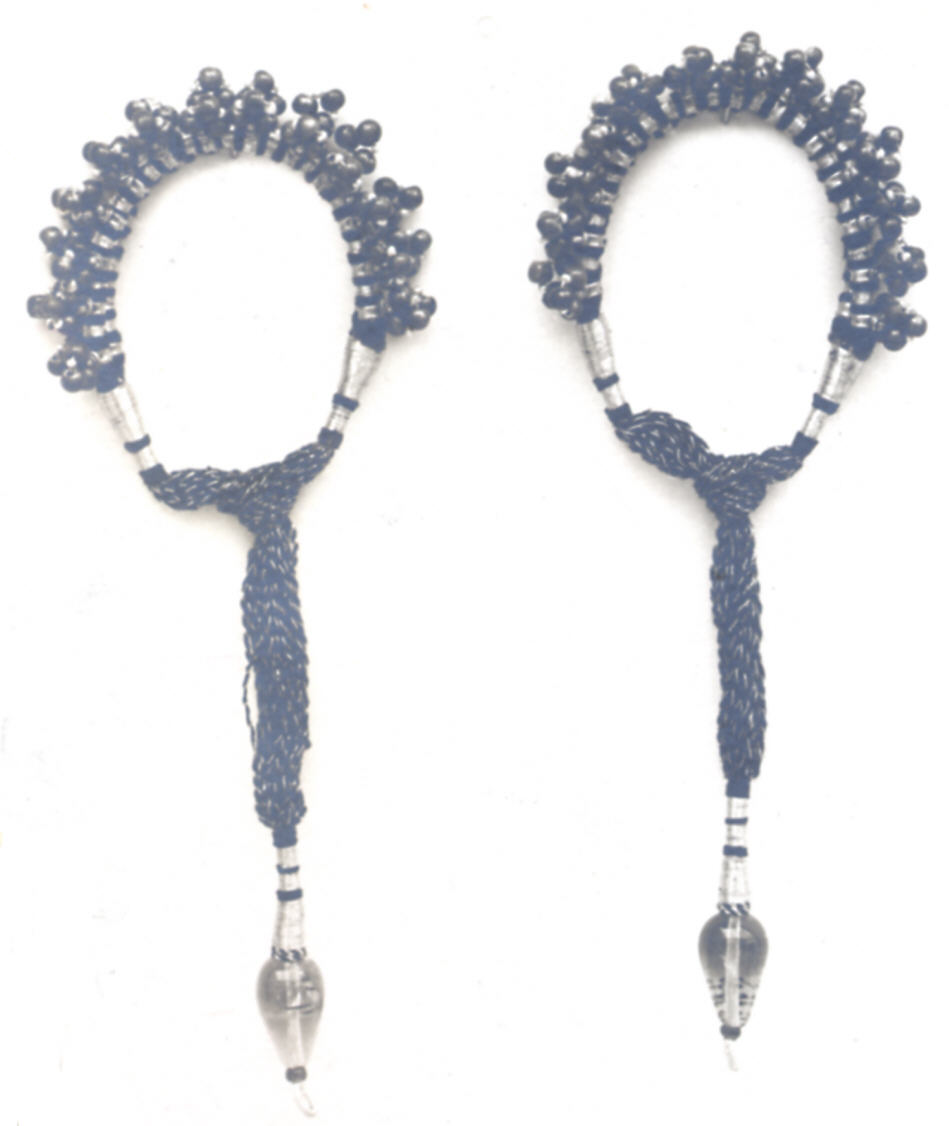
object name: bracelet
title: Bracelet (Bazuband), One of a Pair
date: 1701-1900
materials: gold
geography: india